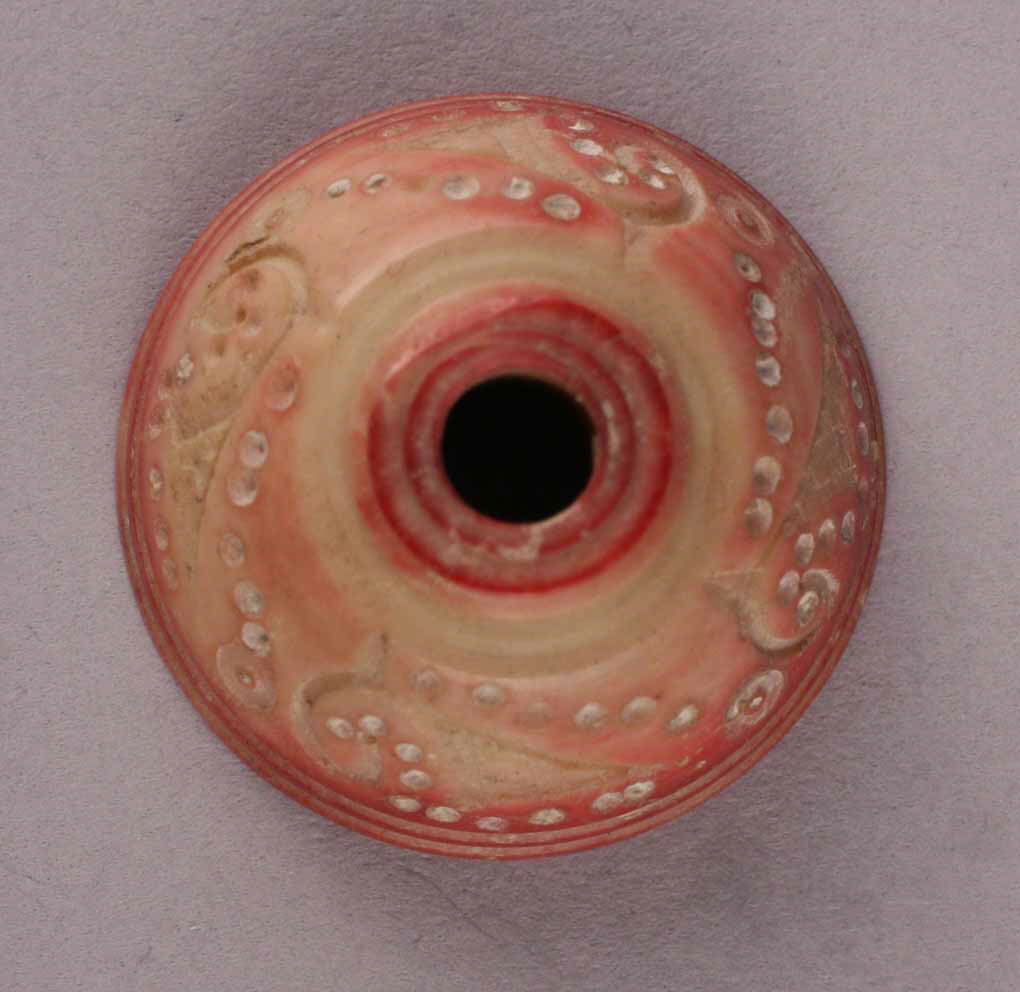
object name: spindle whorl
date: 801-1000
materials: bone, paint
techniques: incising, inlay, tinting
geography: iran